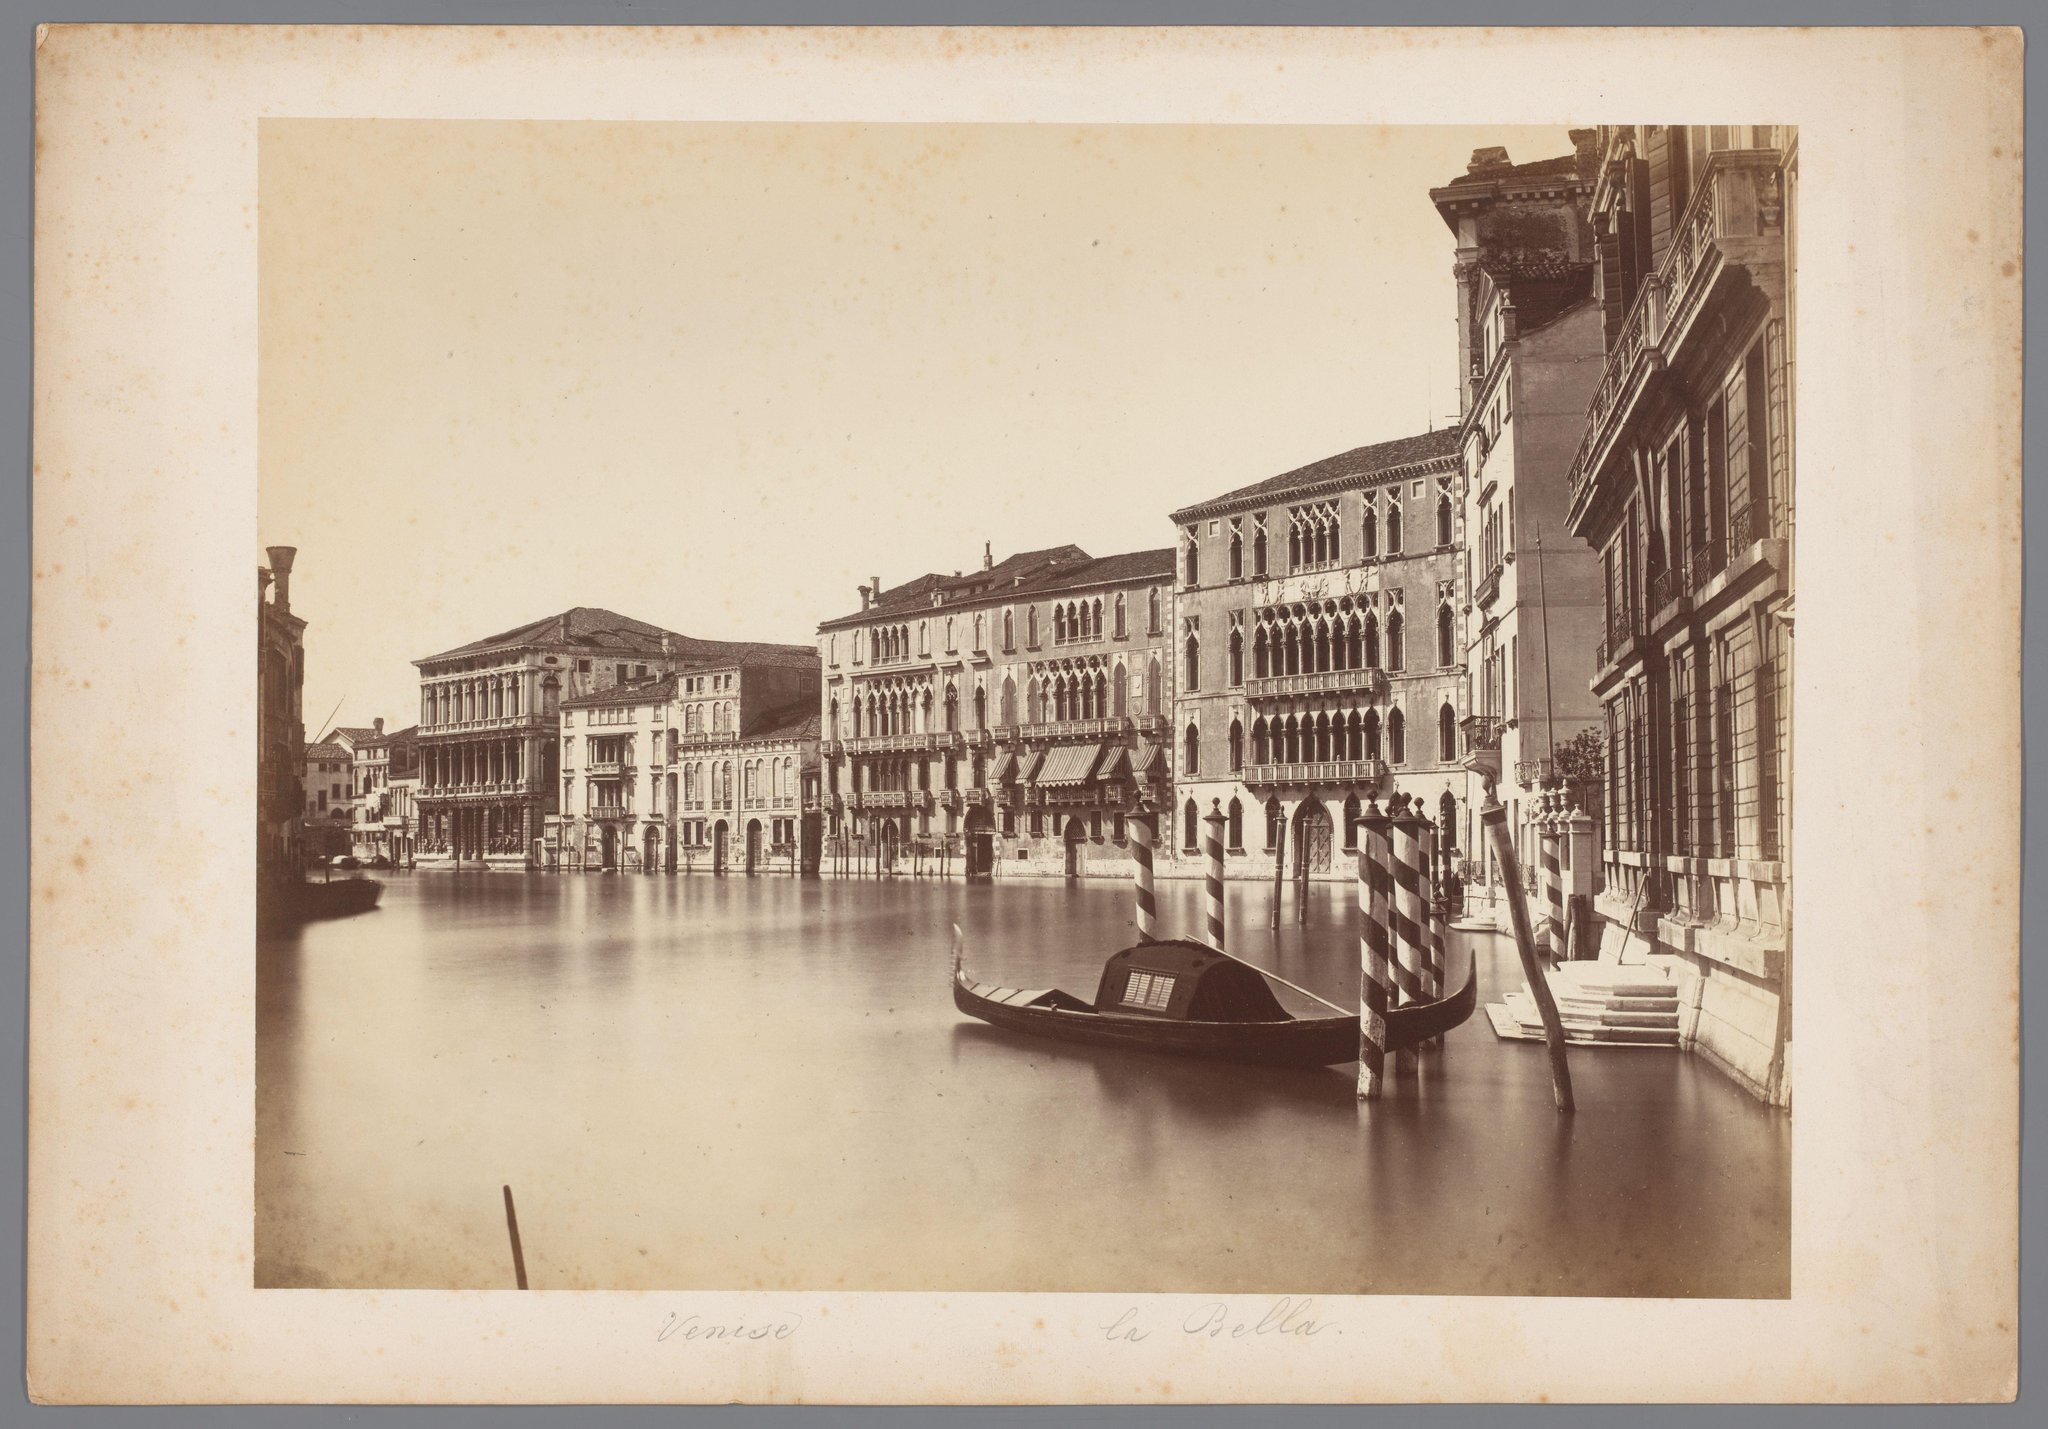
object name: photograph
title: Canal Grande dal Palazzo Grimani a S. Polo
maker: carlo ponti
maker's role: fotograaf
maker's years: 1820-1893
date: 1852-1893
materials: cardboard, paper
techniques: albumen print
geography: venice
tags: urban housing, canals, waters (in city)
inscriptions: inscription: ‘Venise la Bella’, inscription: ‘(Deposé)’, inscription: ‘Commençant à droite: Palais Foscari (...)’